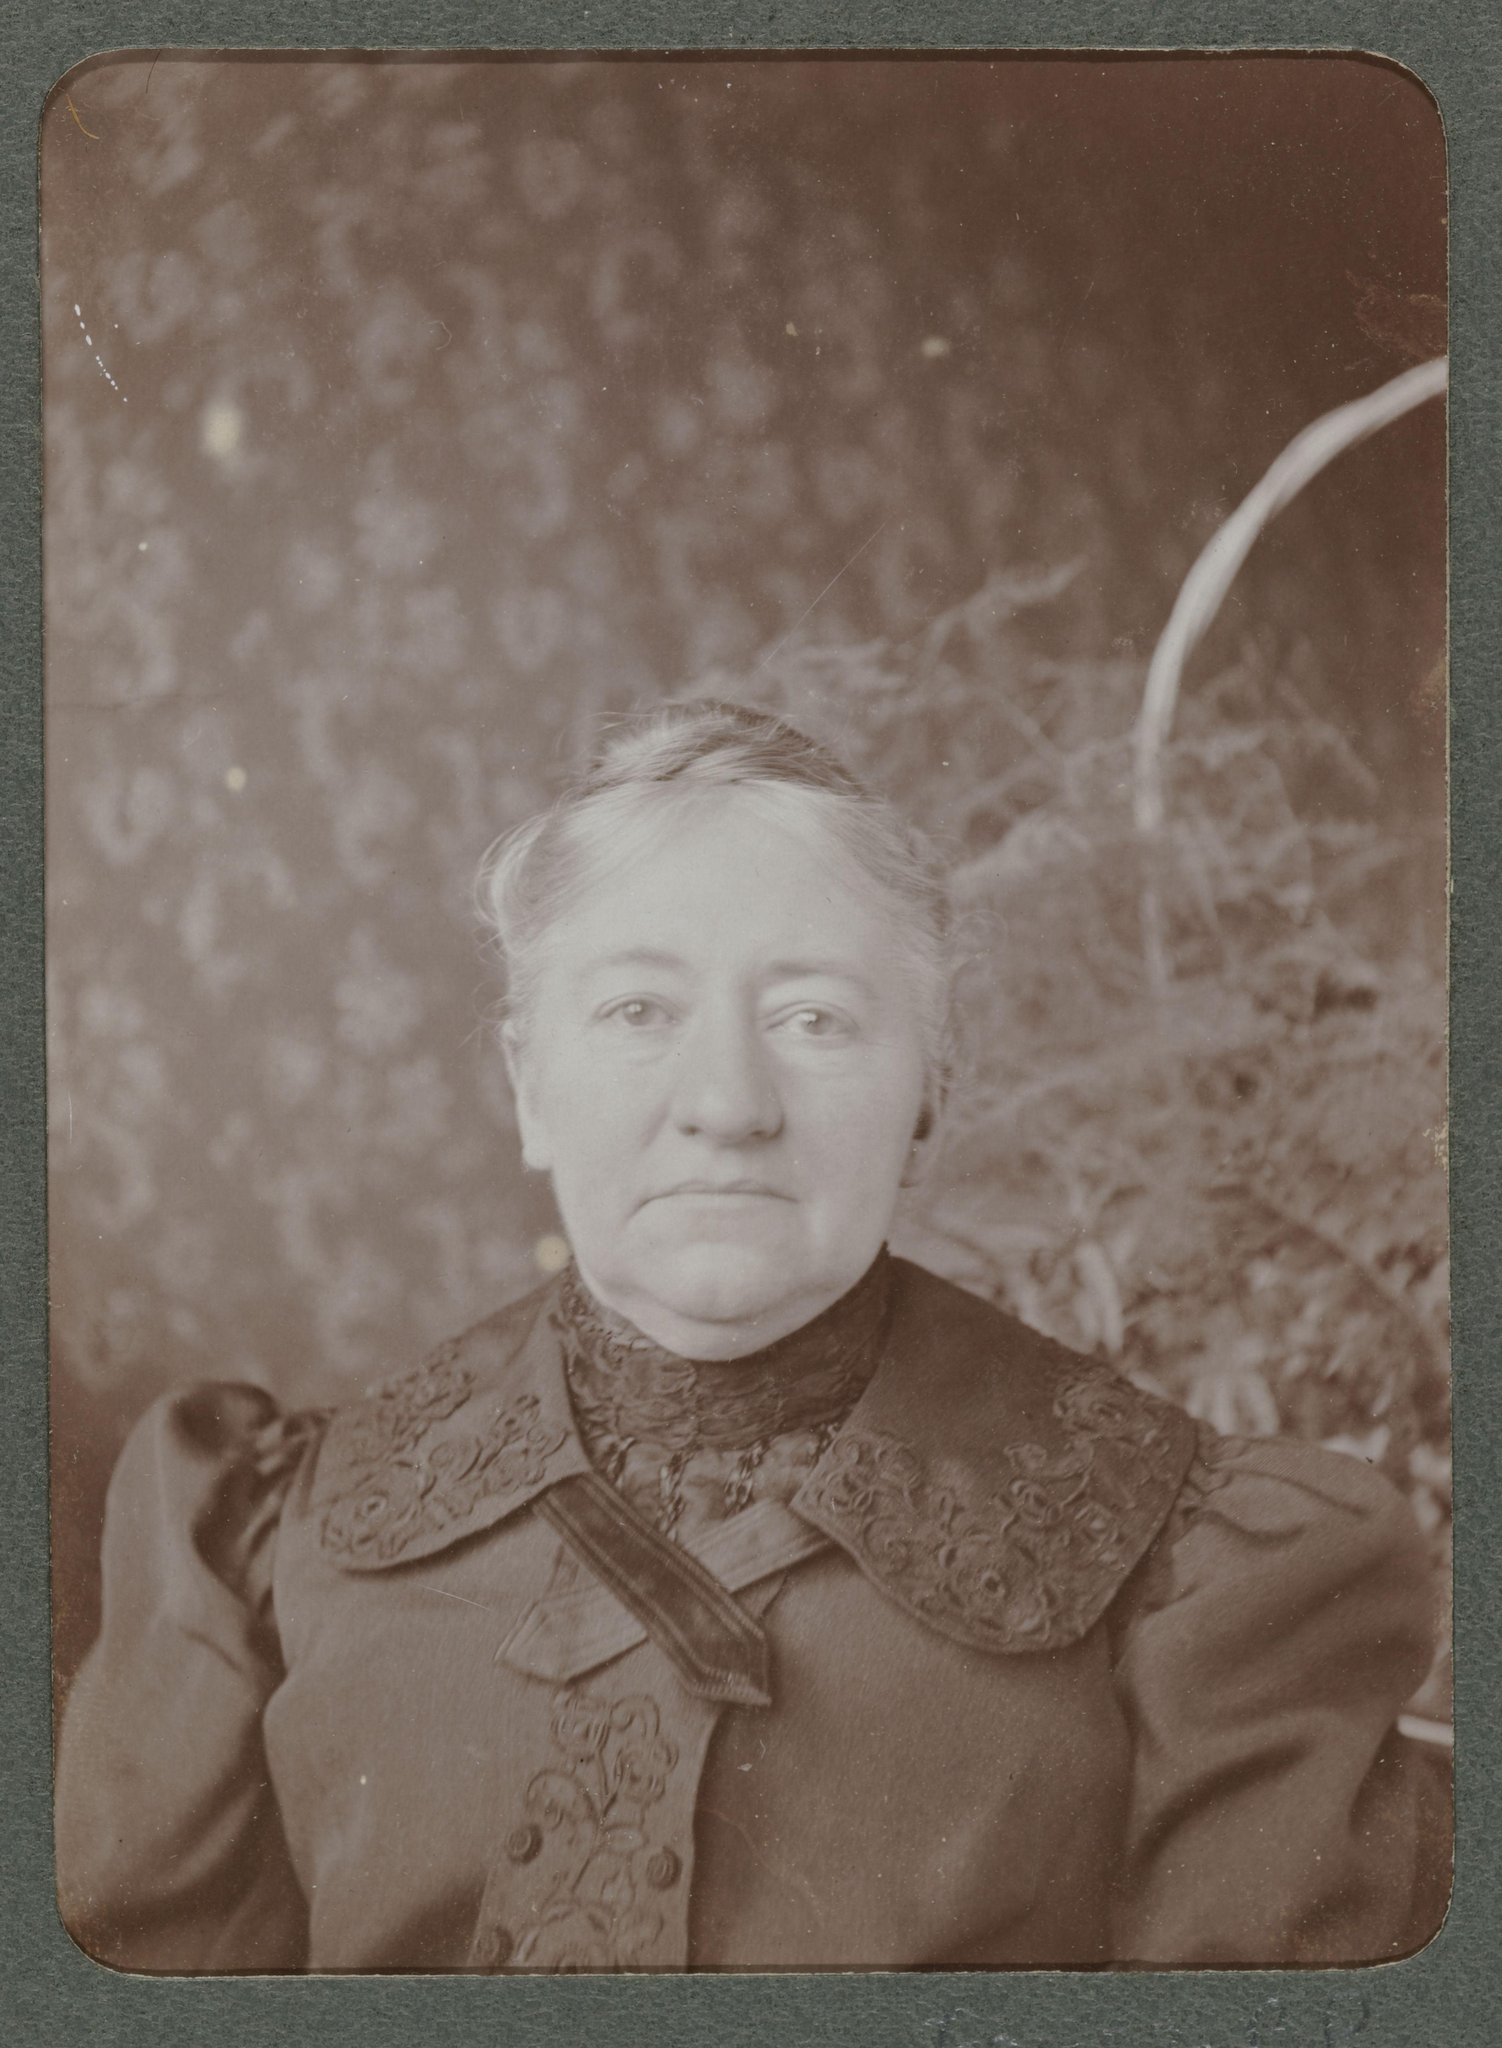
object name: album leaf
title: Portret van een zittende vrouw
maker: christiaan otto roelofs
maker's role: fotograaf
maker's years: 1882-1970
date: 1900-1915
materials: photographic support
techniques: collodion silver print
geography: netherlands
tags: historical persons - bb - woman